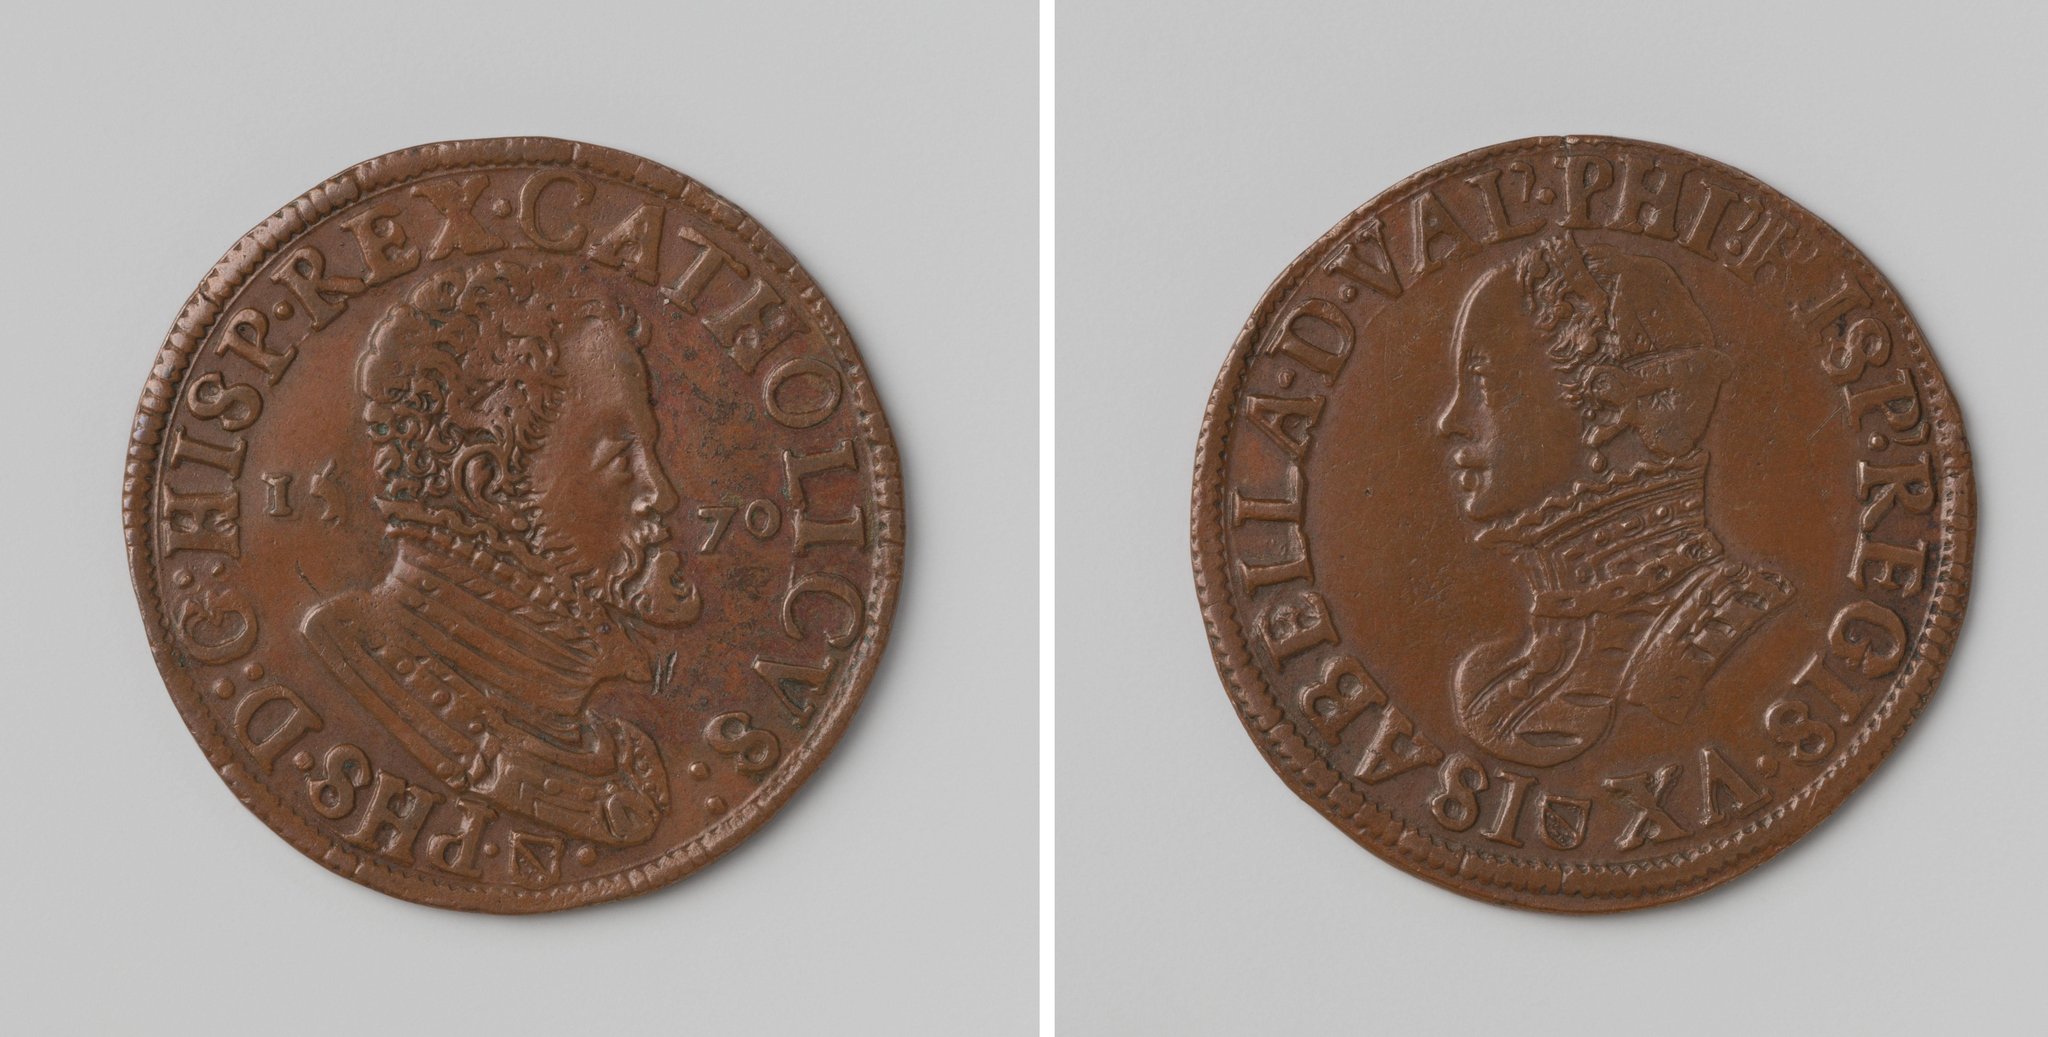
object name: jeton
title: Filips II en Isabella, koning en koningin van Spanje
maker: Anonymous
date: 1570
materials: copper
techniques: striking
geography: utrecht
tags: philip ii of spain, utrecht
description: Koperen penning. Voorzijde: borststuk man tussen jaartal binnen omschrift. Keerzijde: borststuk vrouw binnen omschrift